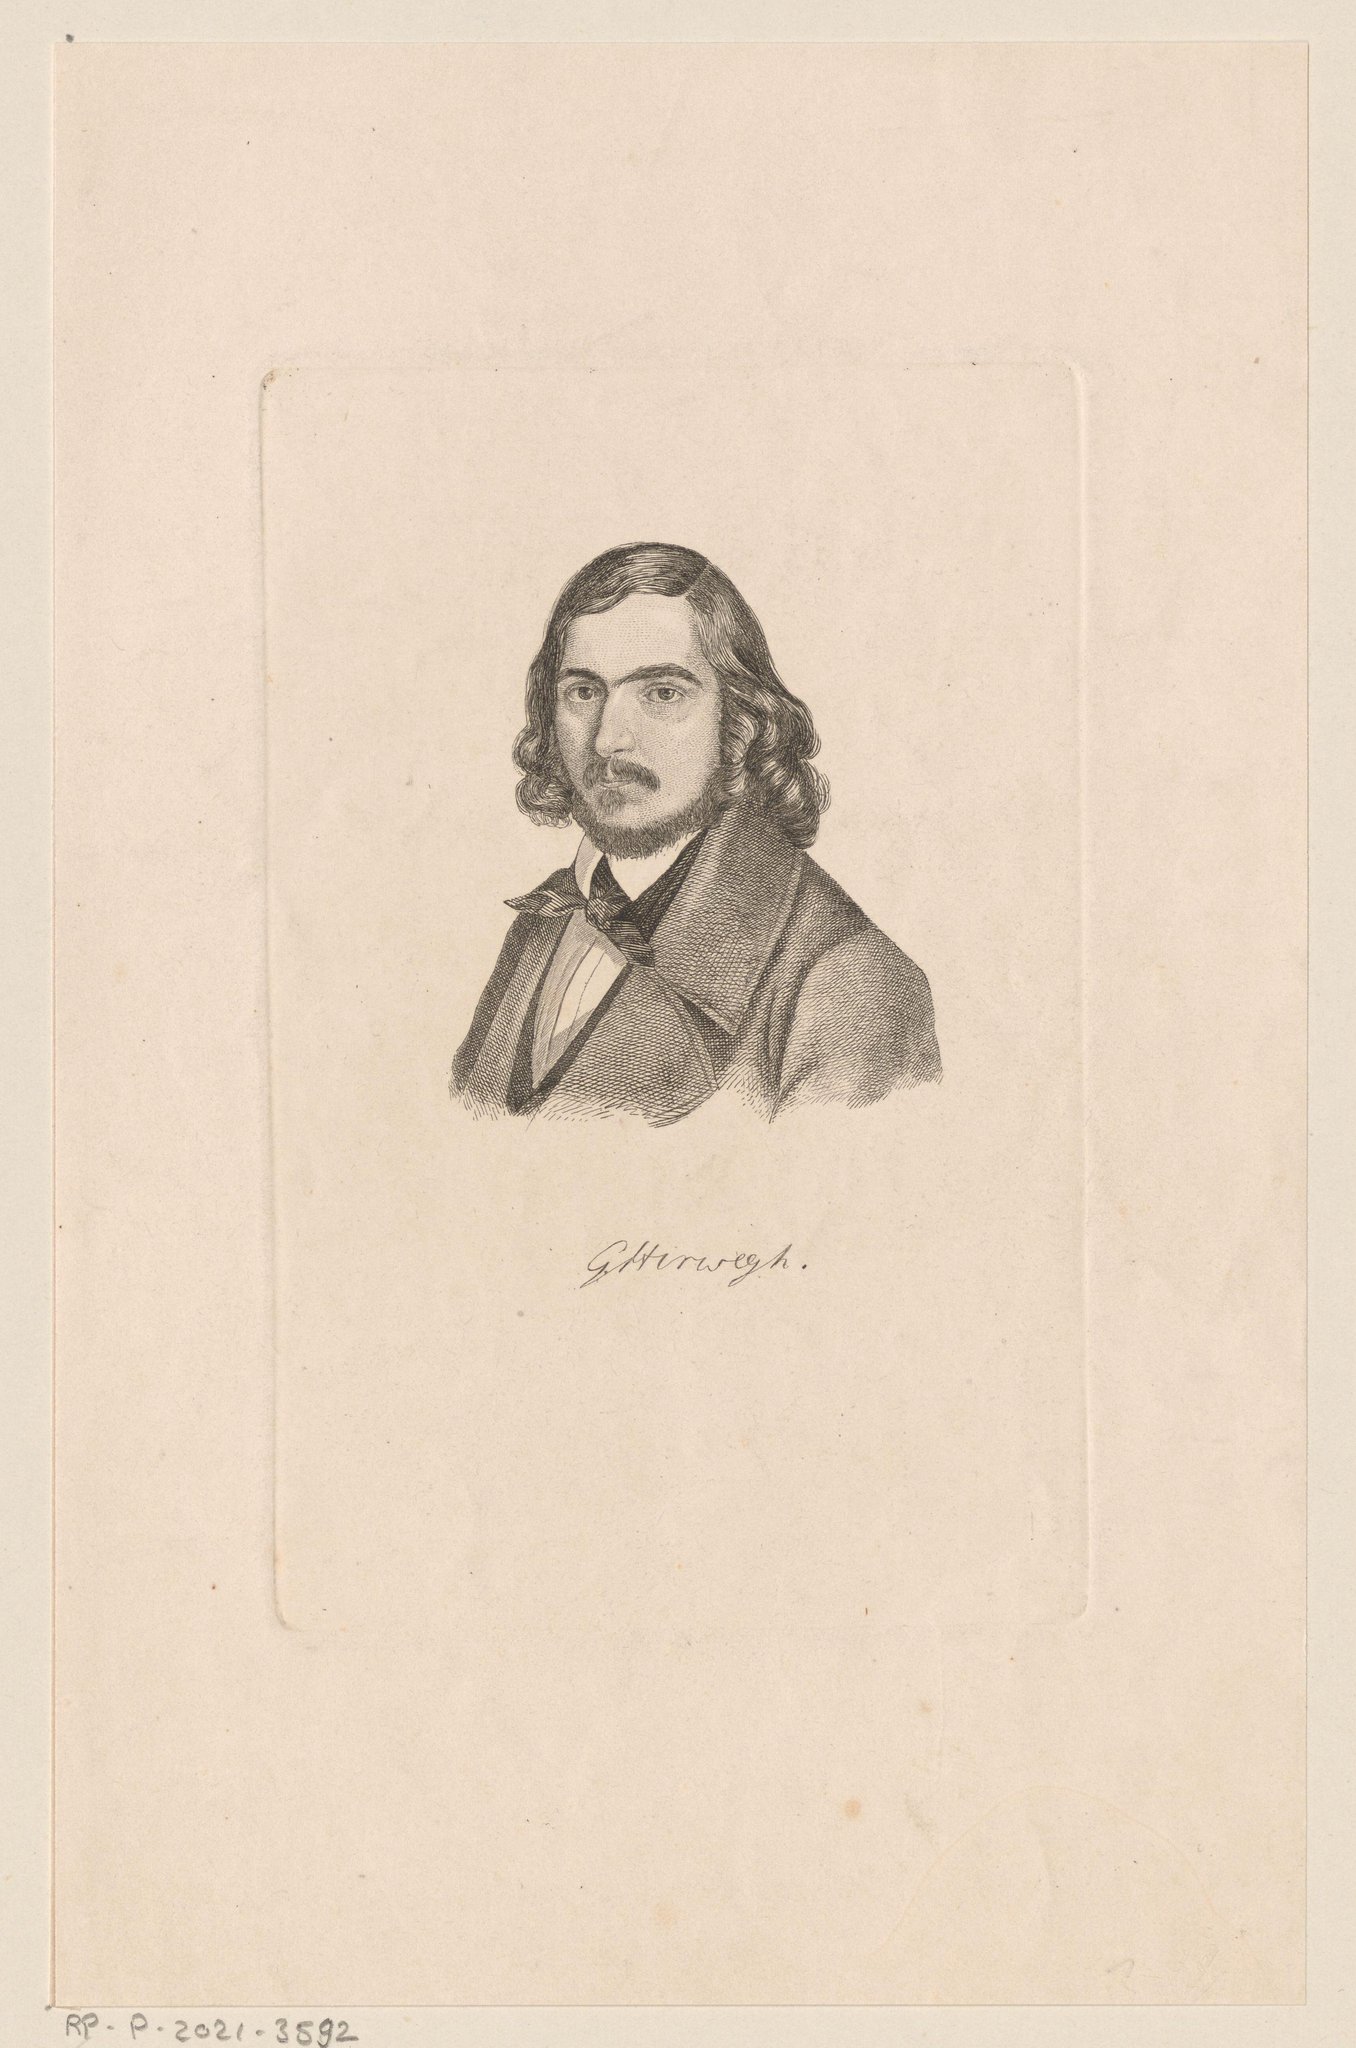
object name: print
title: Portret van Georg Herwegh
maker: Anonymous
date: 1841-1899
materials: paper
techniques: etching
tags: historical persons, writer, poet, author